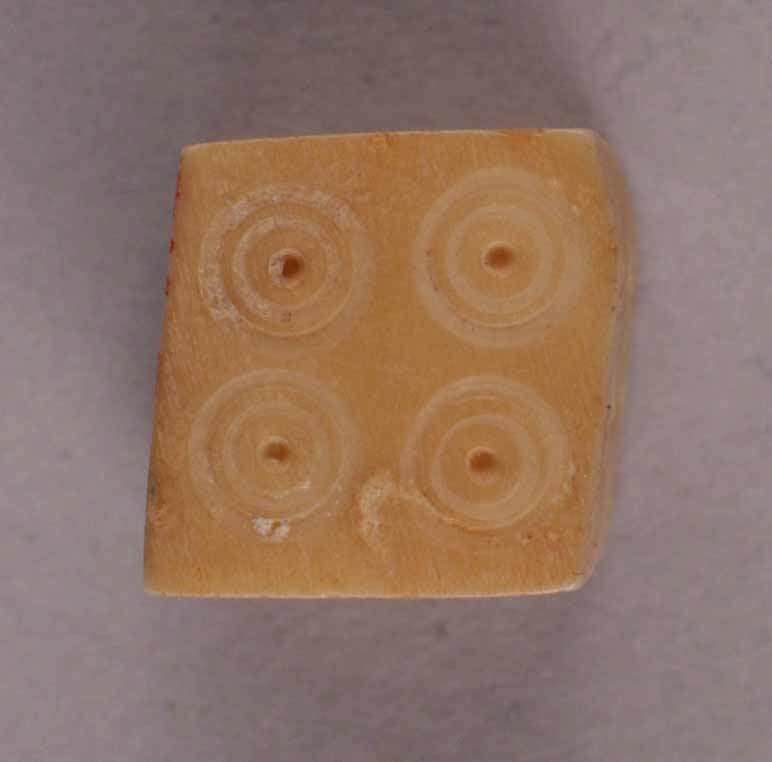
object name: dice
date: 801-1000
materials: bone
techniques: incising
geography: iran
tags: dice